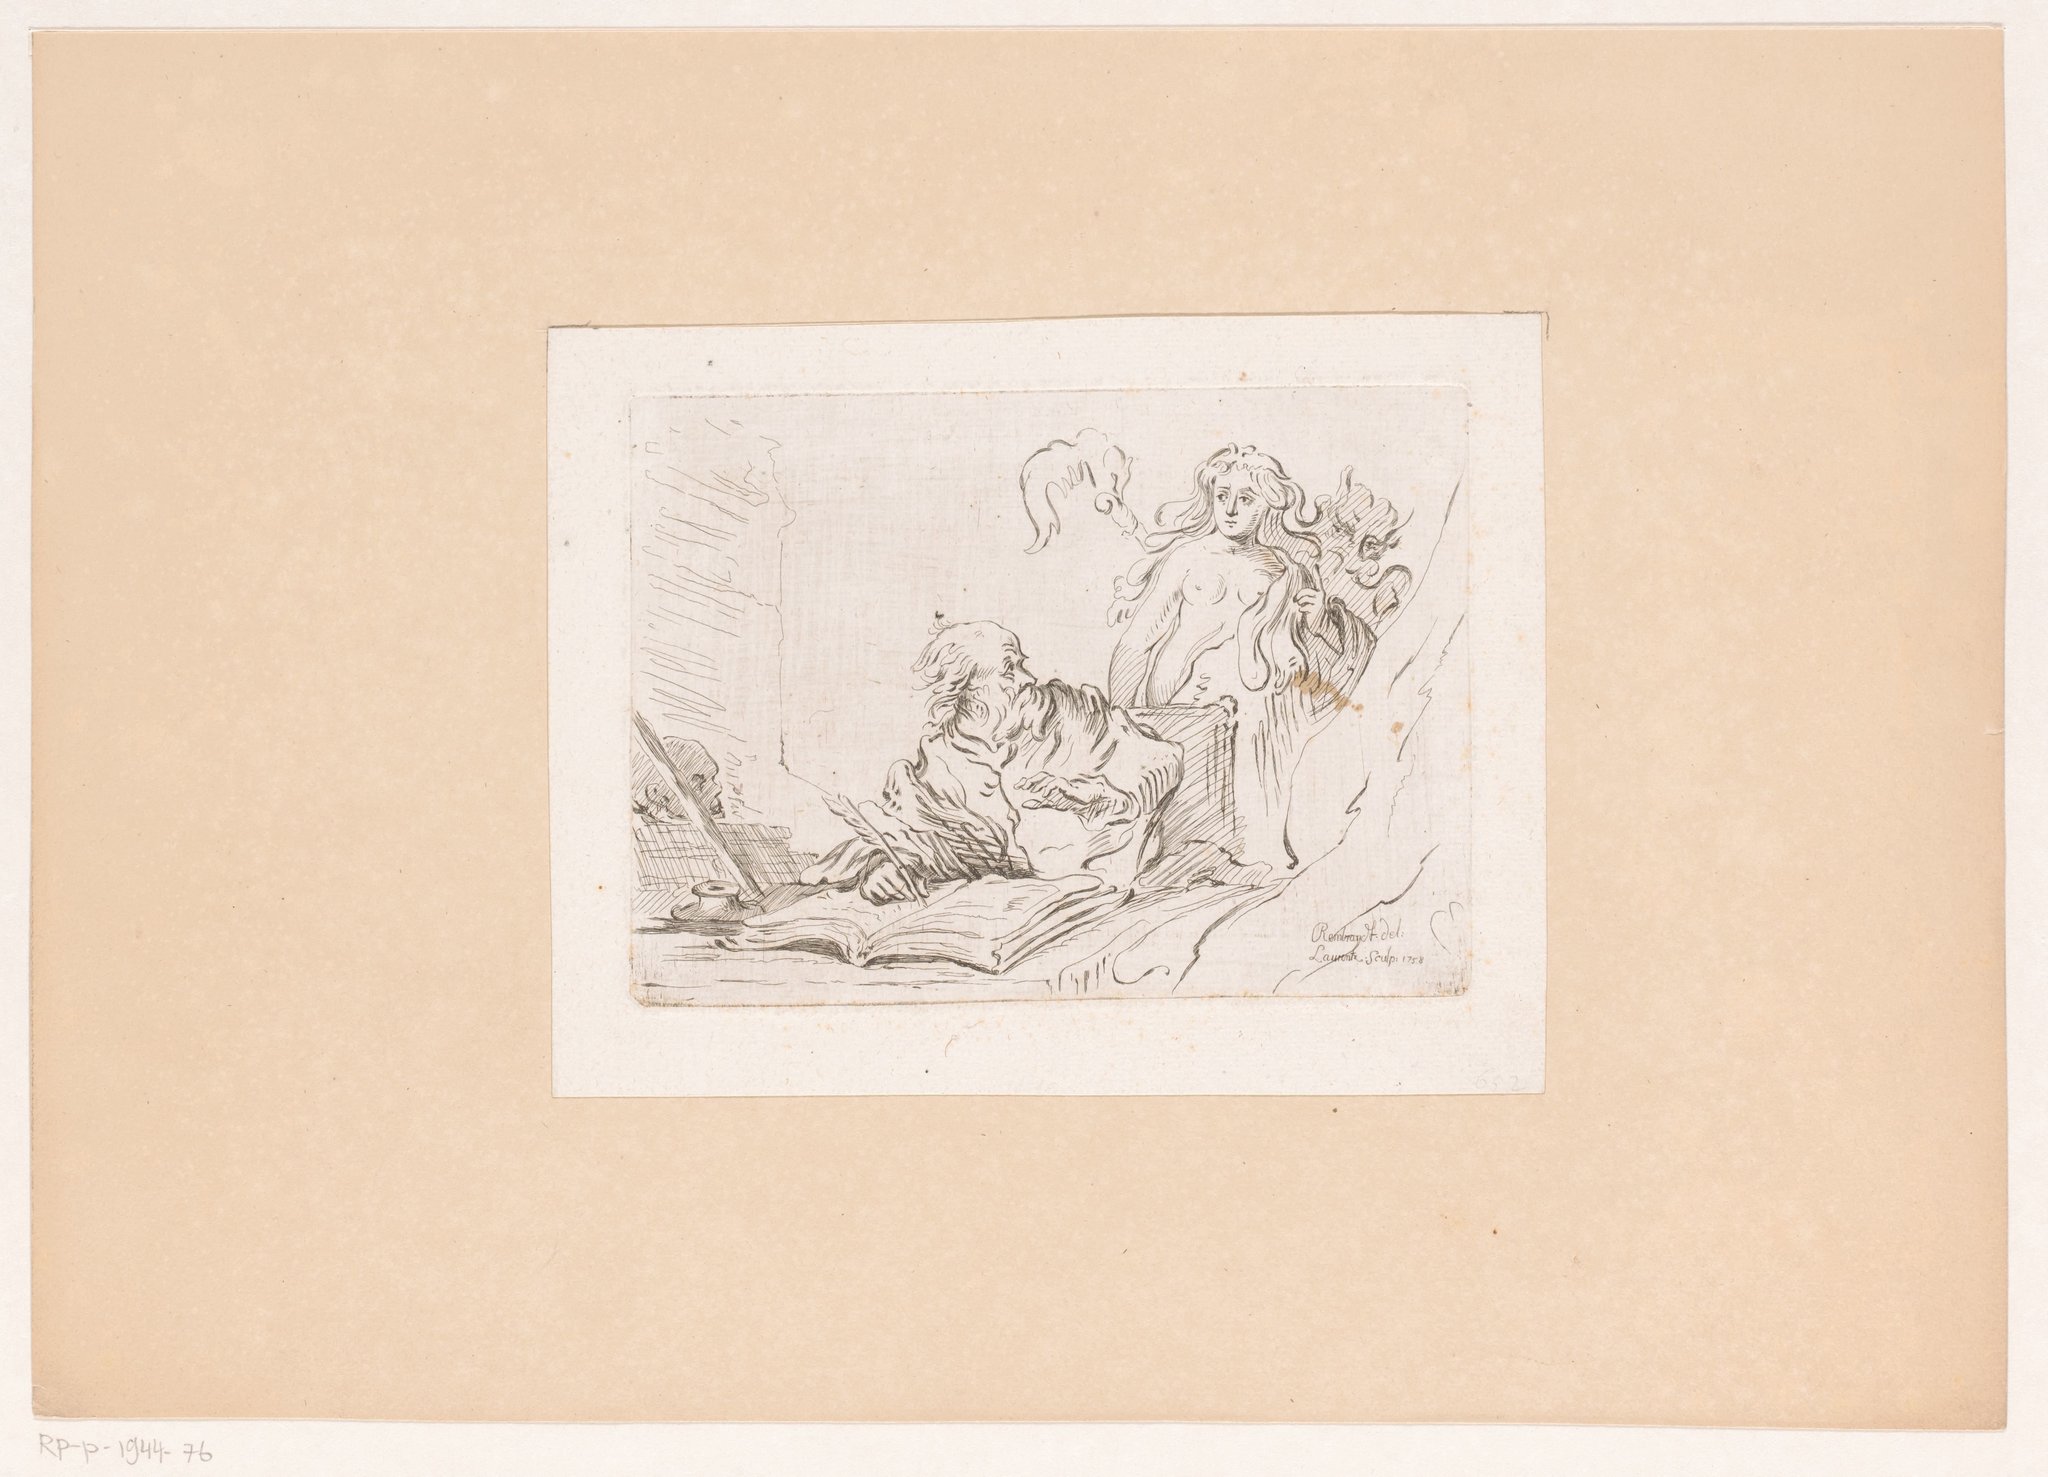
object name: print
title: Oude man aan schrijftafel schrikt op van een vrouw met de duivel als schaduw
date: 1758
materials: paper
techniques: etching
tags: shadow sold to the devil - aa - female human figure, old man, writer, poet, author, human-shaped devils ~ handsome seducer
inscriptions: collector's mark: Lugt 2228, collector's mark: Lugt 240